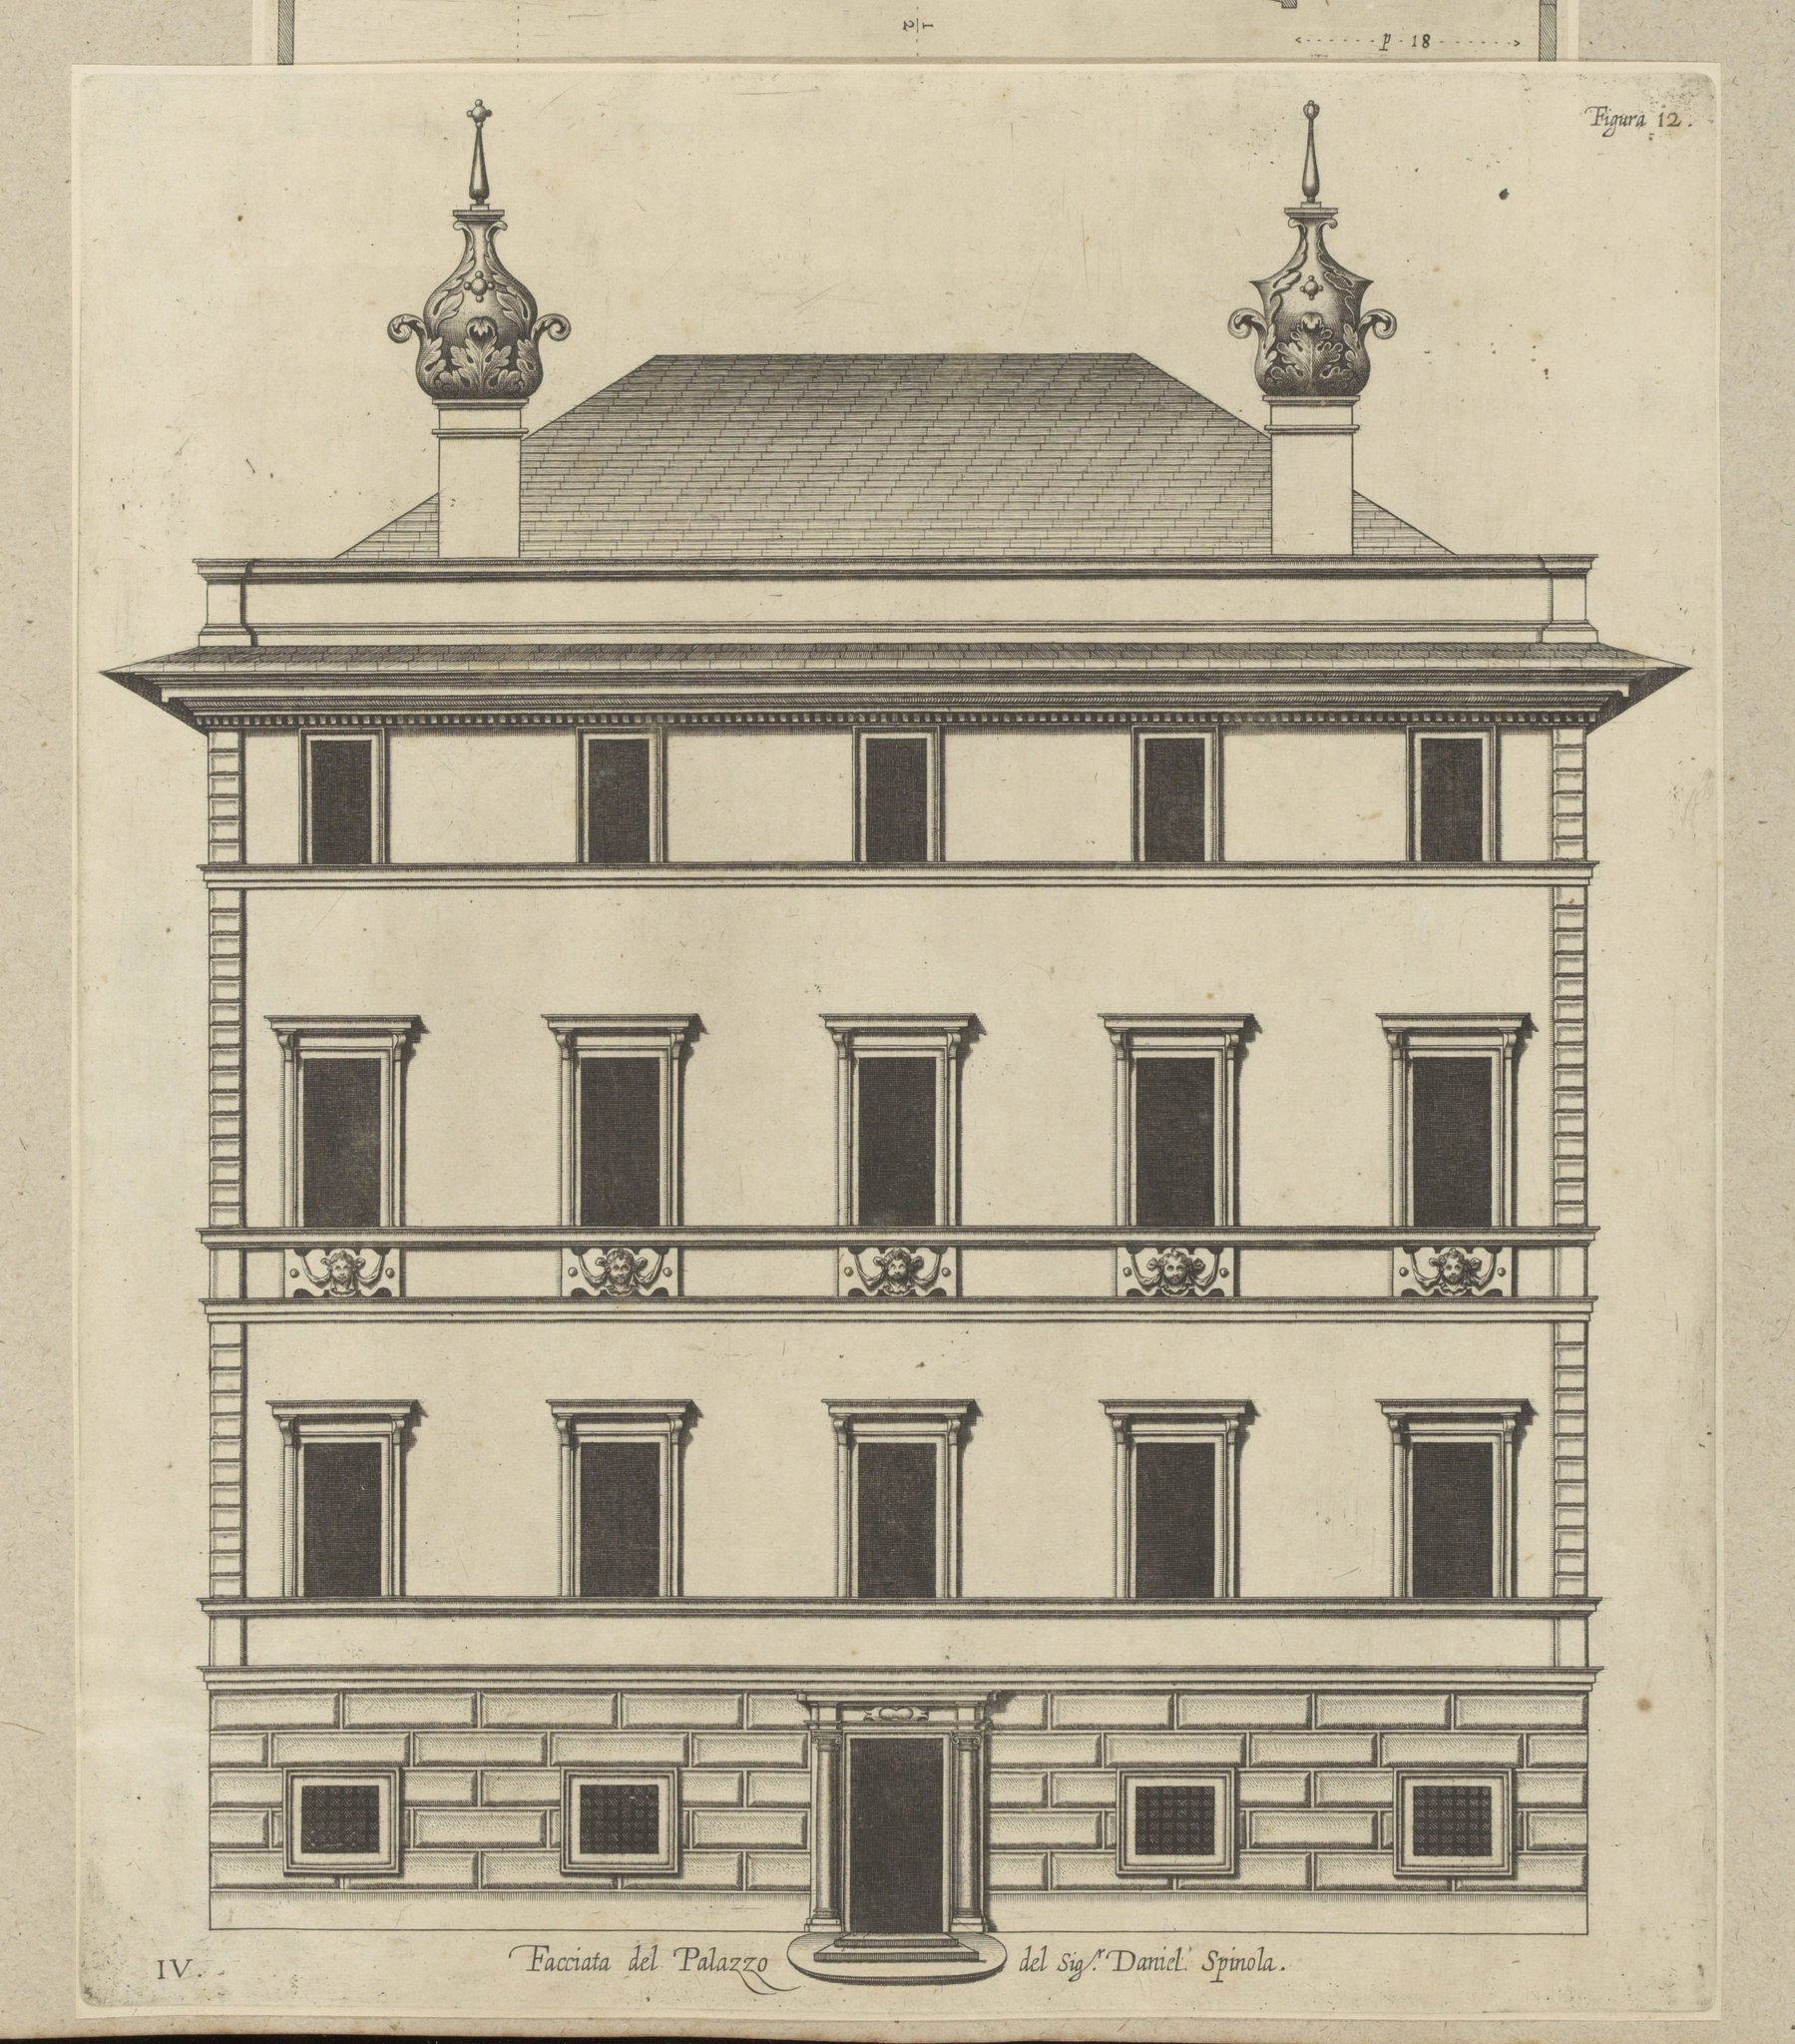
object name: album leaf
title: Facciata del Palazzo del sigr. Daniel Spinola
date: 1622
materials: paper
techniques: engraving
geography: antwerp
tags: hôtel, i.e. small palace in city, façade (of house or building), exterior ~ architectural design or model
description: Deze prent maakt deel uit van een album.